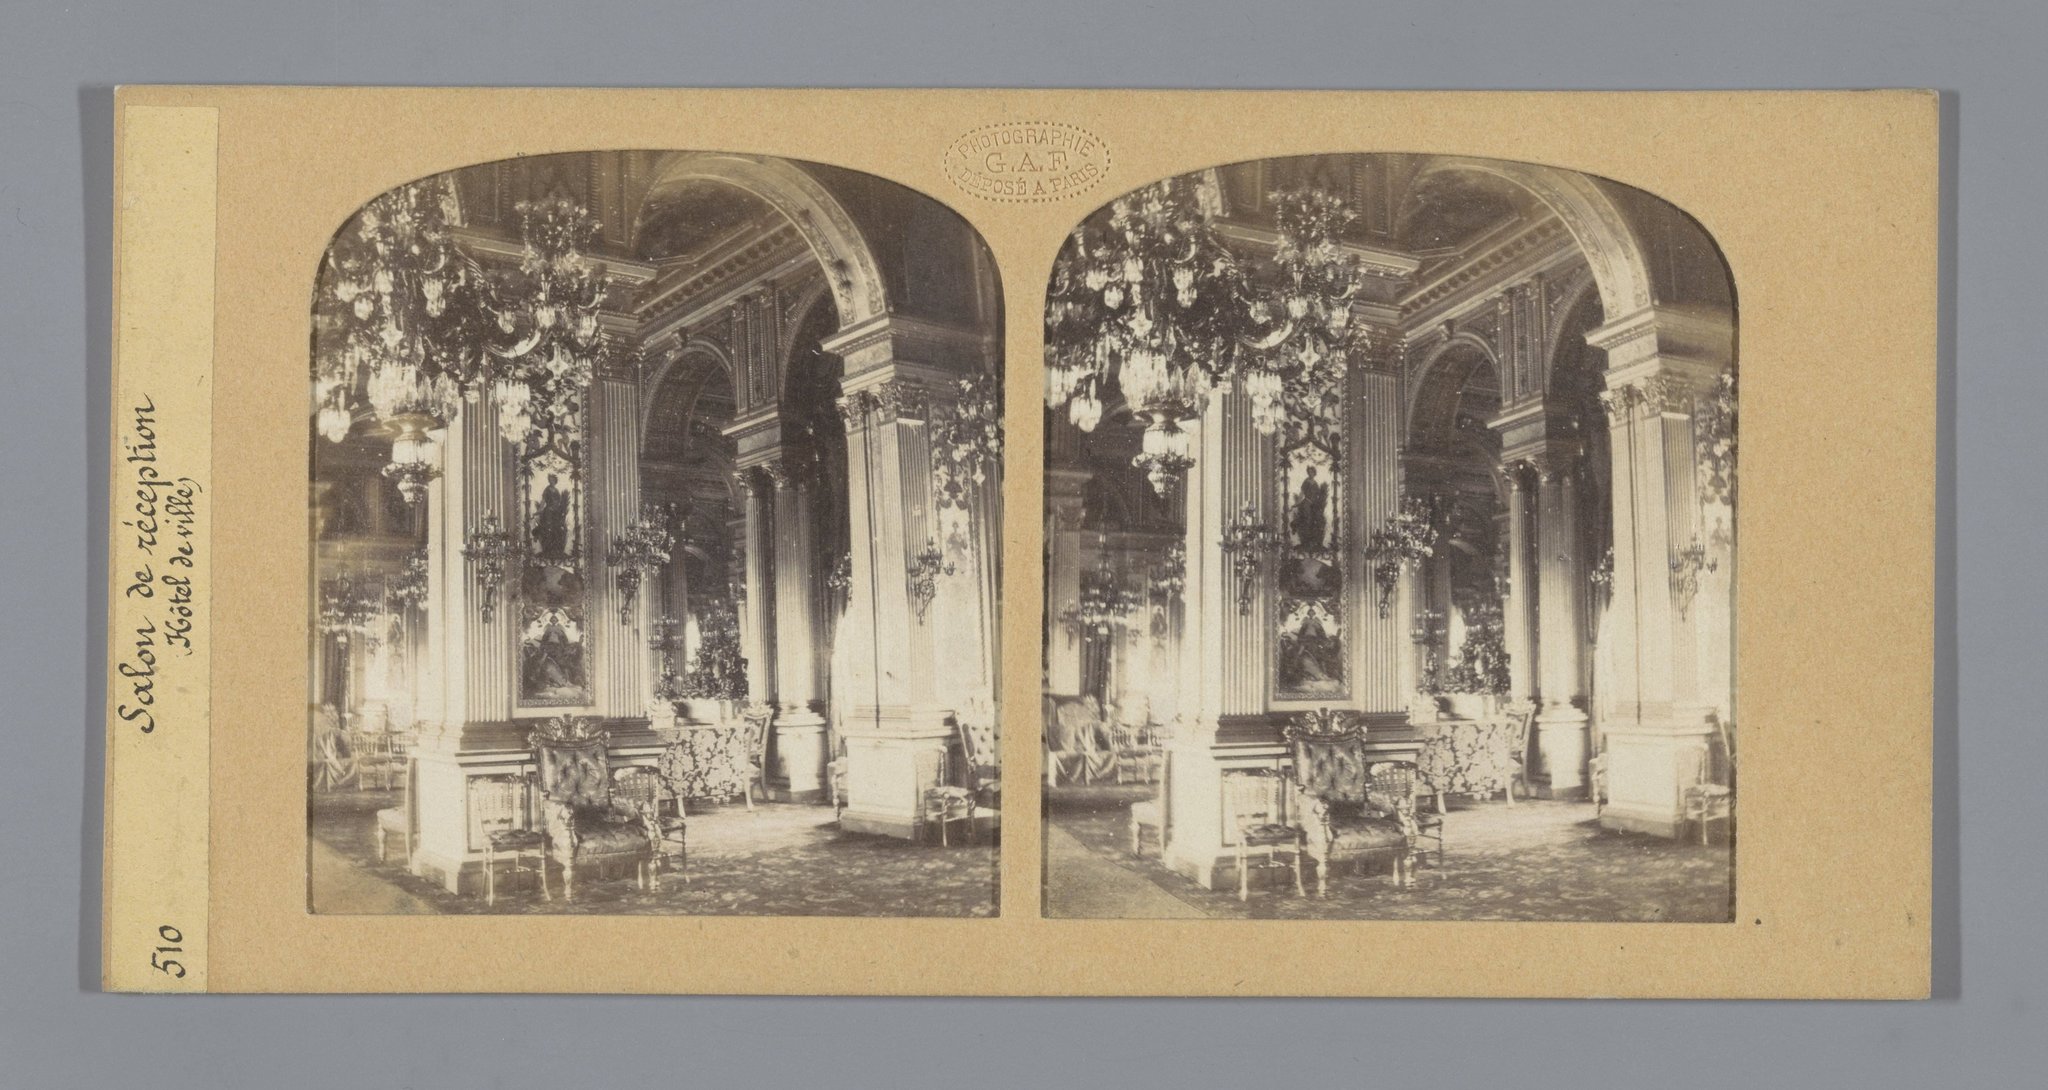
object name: tissue stereograph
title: Salon de réception (Hôtel de Ville)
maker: florent grau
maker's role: manufacturer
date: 1855-1864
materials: cardboard, paper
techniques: albumen print, hand coloring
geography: paris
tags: palace - aa - civic architecture: inside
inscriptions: number: ‘510’, inscription: ‘Déposé a Paris’